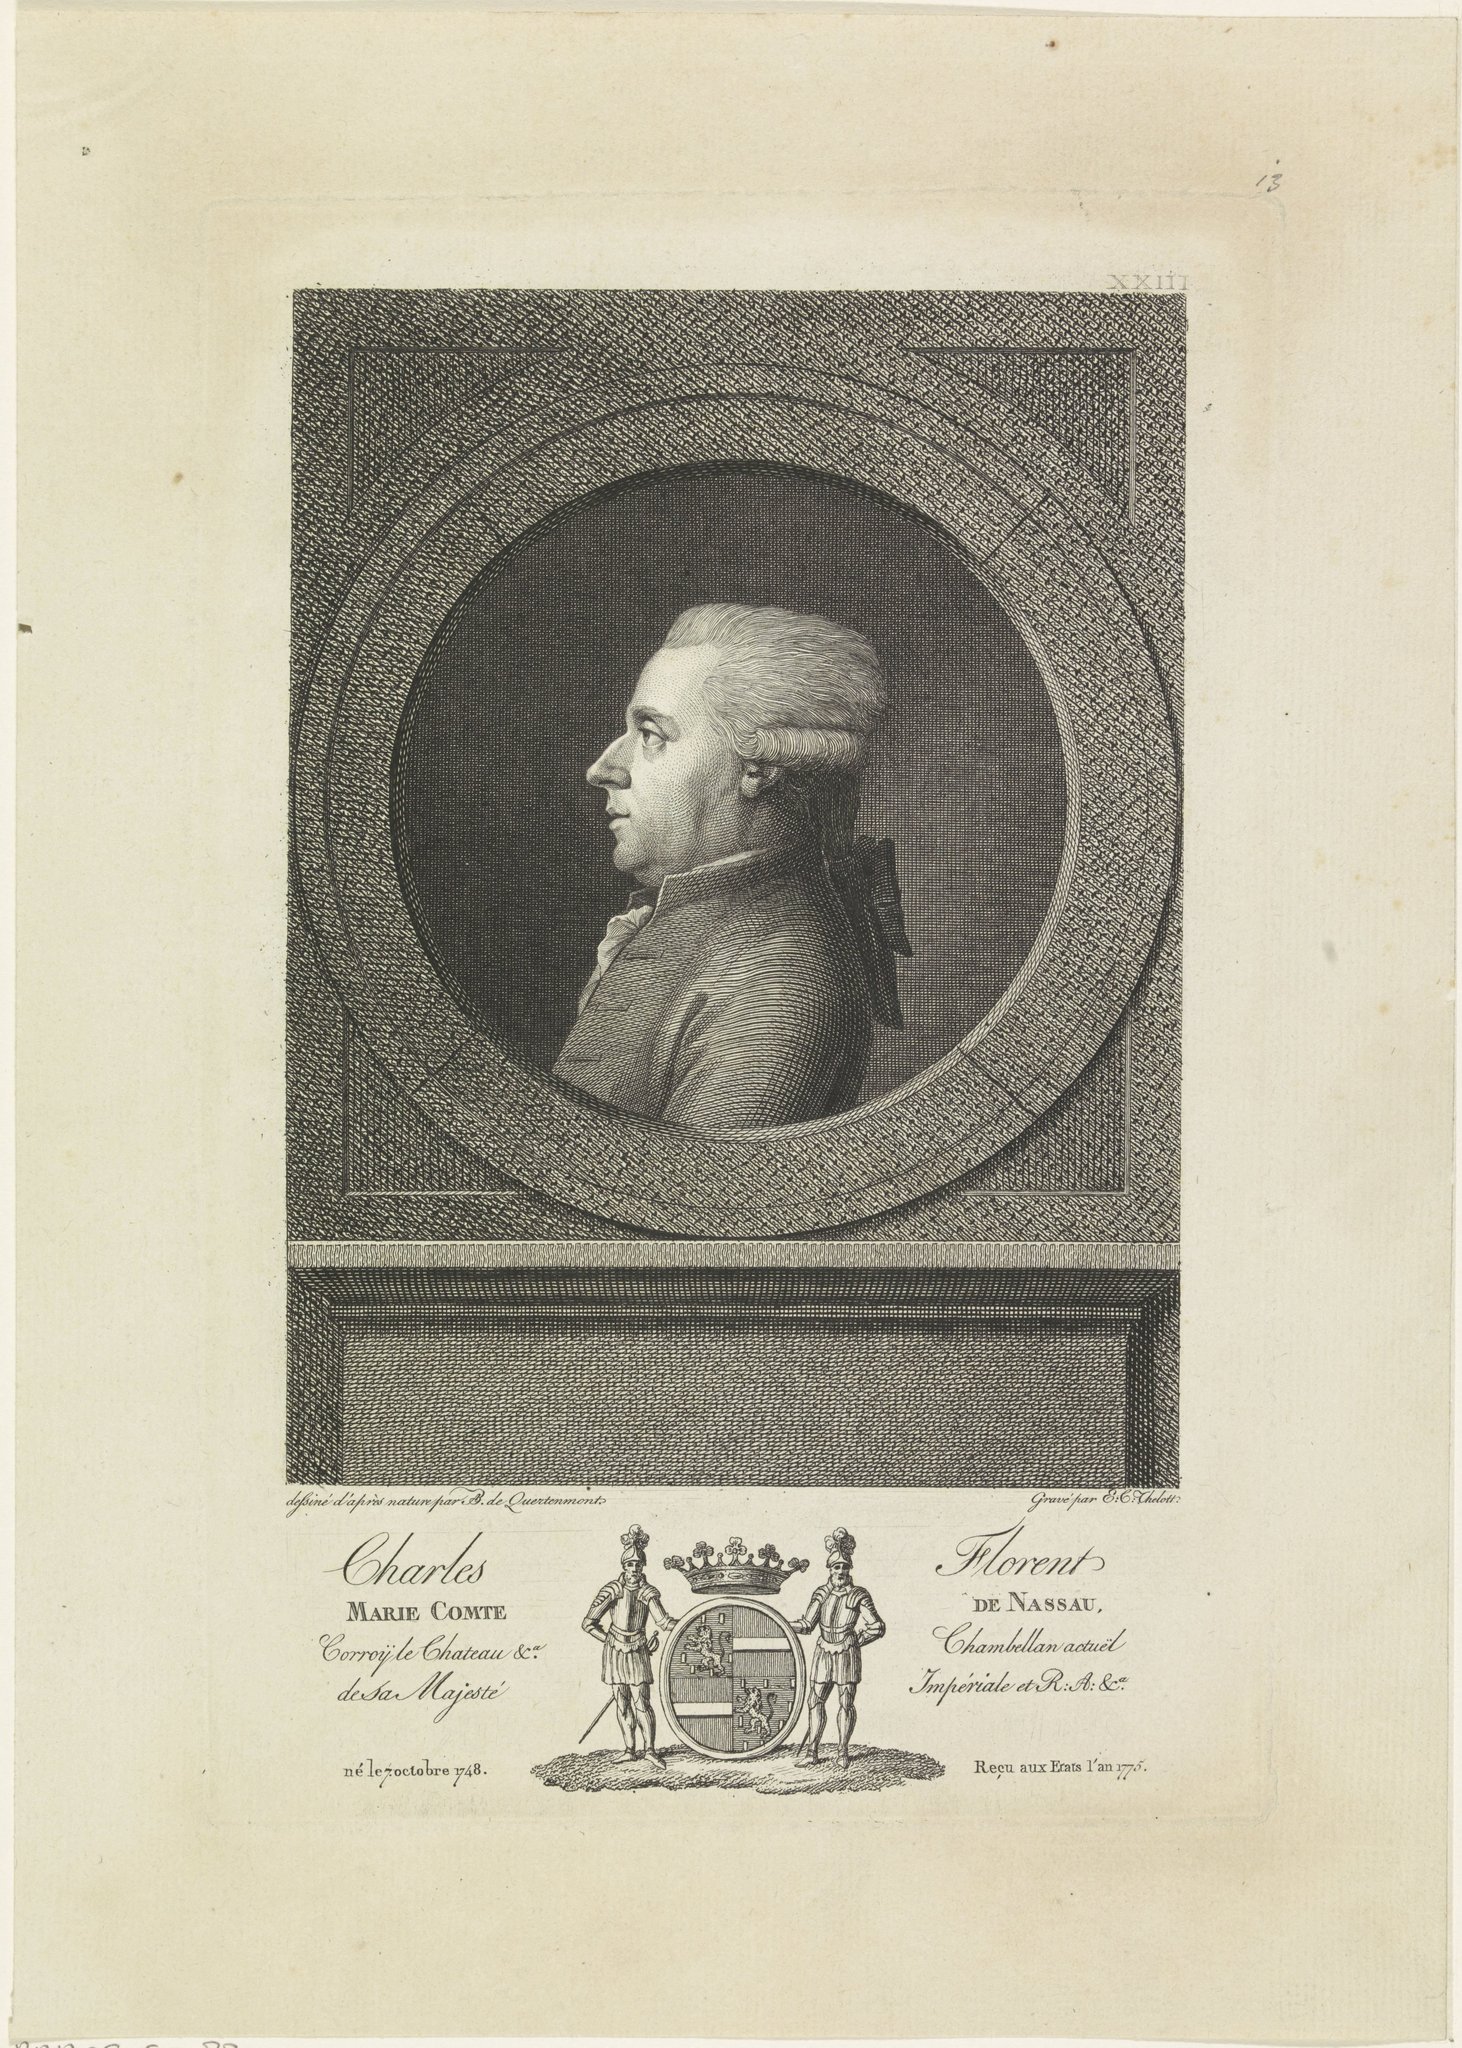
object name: print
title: Portret van Charles Florent Marie van Nassau-Corroy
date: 1775-1834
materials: paper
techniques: engraving, etching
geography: germany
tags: charles florent marie van nassau-corroy, huis nassau ottoonse linie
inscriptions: collector's mark: Lugt 2228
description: Portret van Charles Florent Marie in een cirkel. Midden onder zijn wapen met een kroon en twee figuren. In de ondermarge vijf regels Franse tekst.